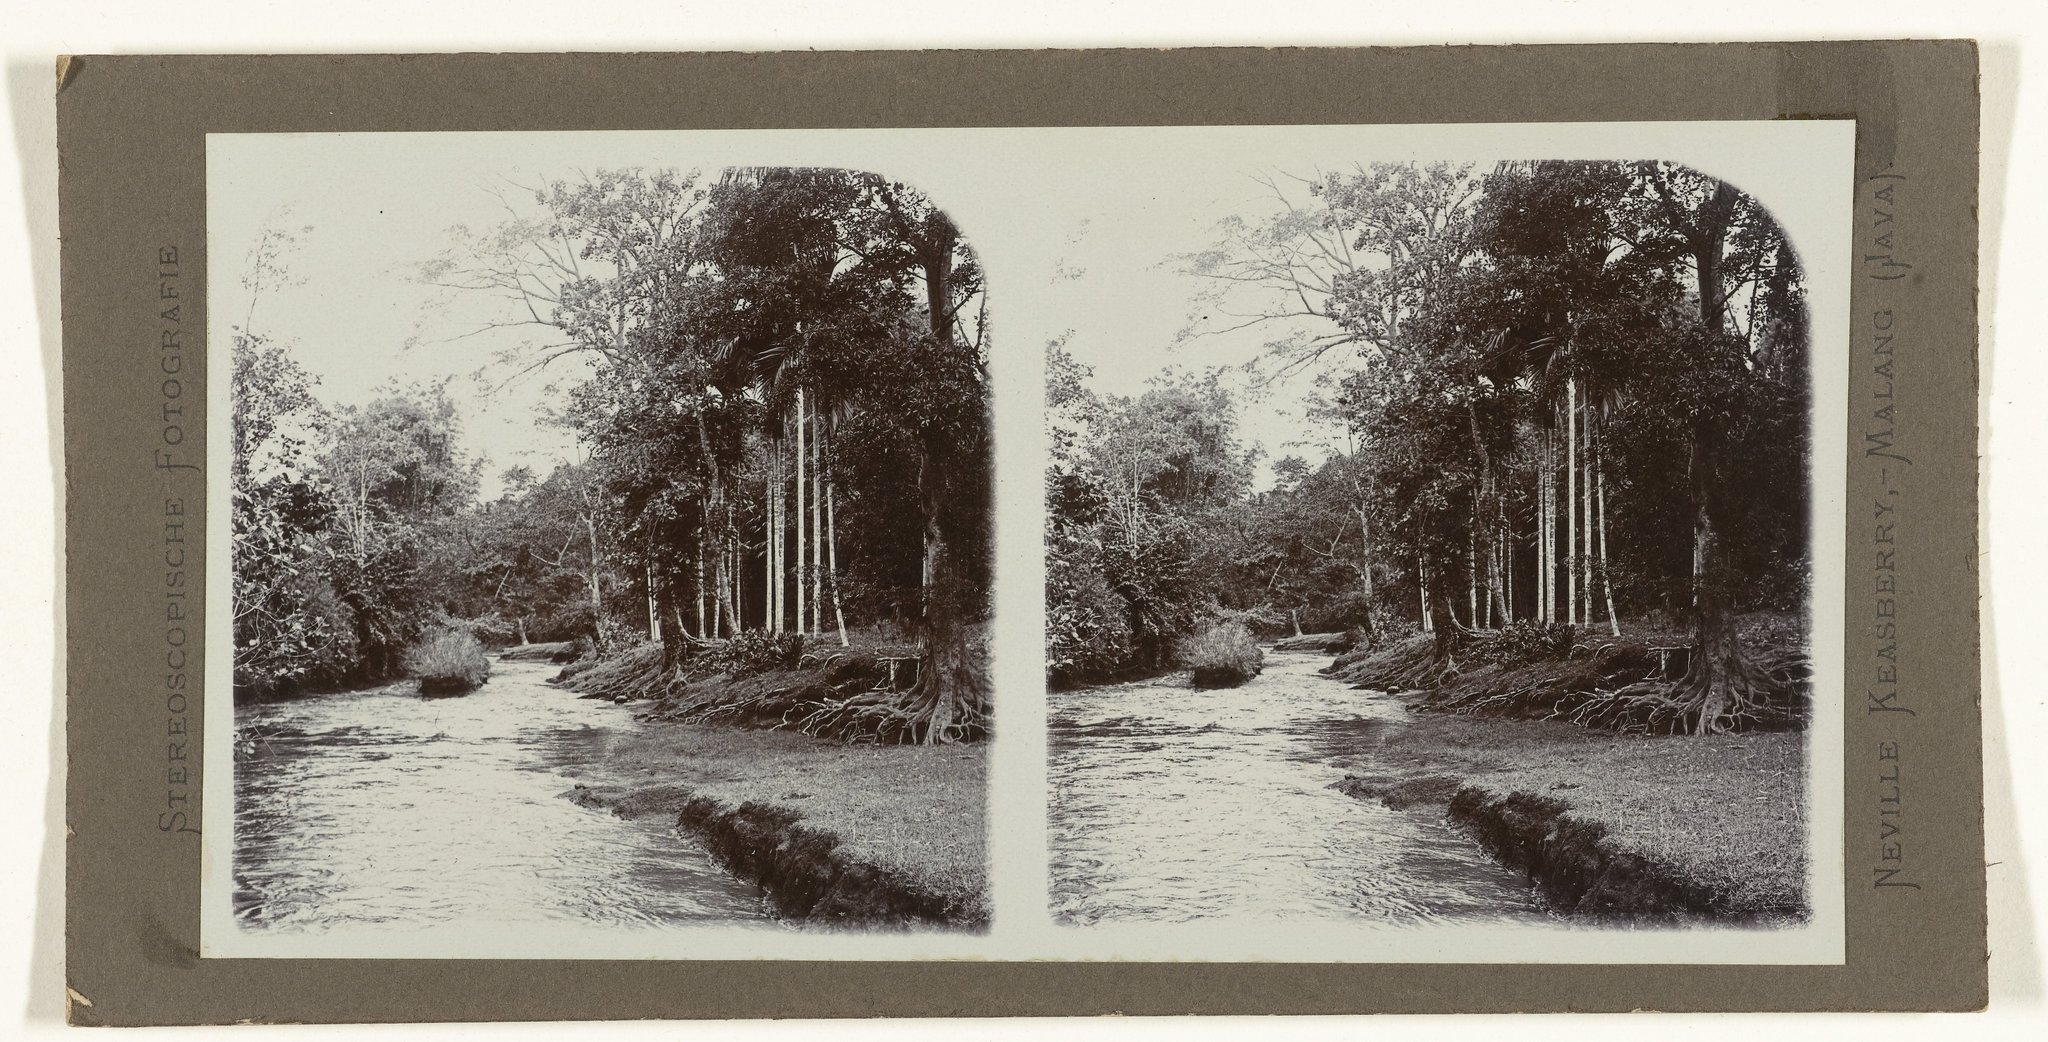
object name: stereograph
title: Bos en rivier landschap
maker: neville keasberry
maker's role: fotograaf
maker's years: 1866-1944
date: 1911-1935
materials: cardboard, paper, photographic support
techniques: albumen print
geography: malang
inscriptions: title: ‘S 7 No 82. Een landschap.’, signature: ‘Neville Keasberry, Malang (Java)’, inscription: ‘Stereoscopische Fotografie’